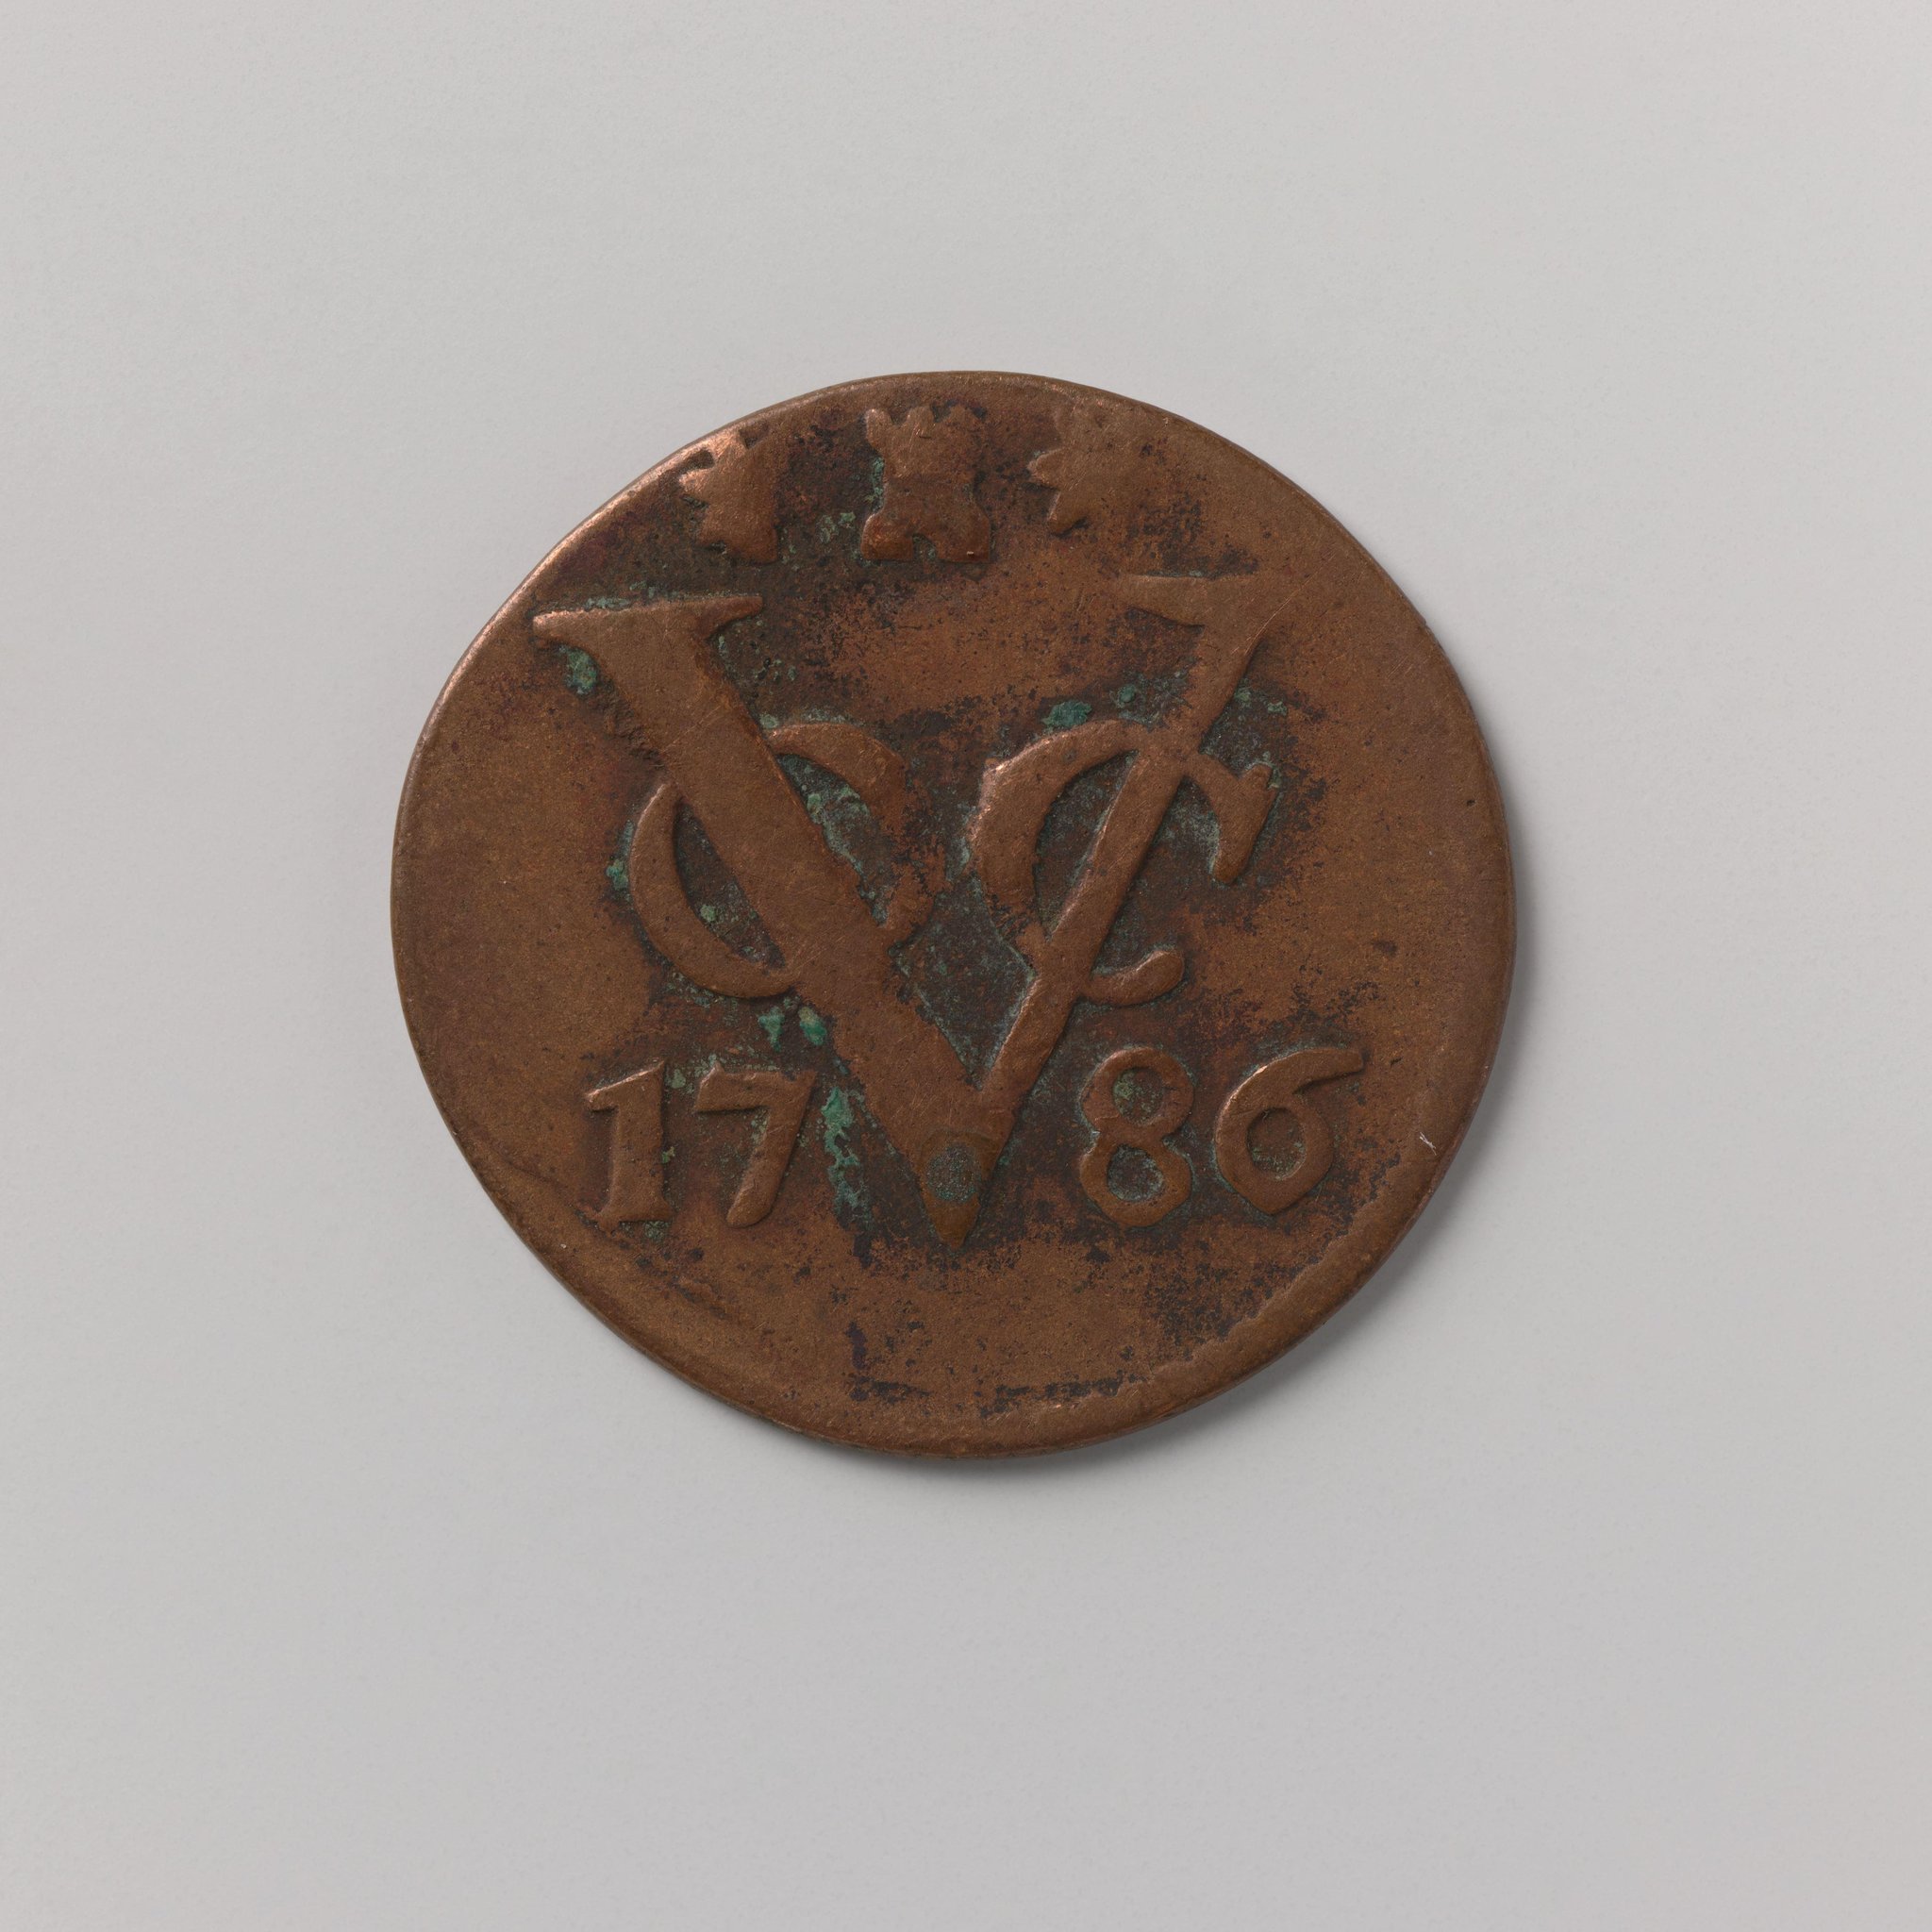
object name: coin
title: VOC, duit Zeeland, 1786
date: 1786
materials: copper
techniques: striking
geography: middelburg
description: Koperen munt. Voorzijde: gekroond wapenschild van Zeeland. Keerzijde: monogram van de VOC, waarboven muntteken en waaronder jaartal. Gladde rand.